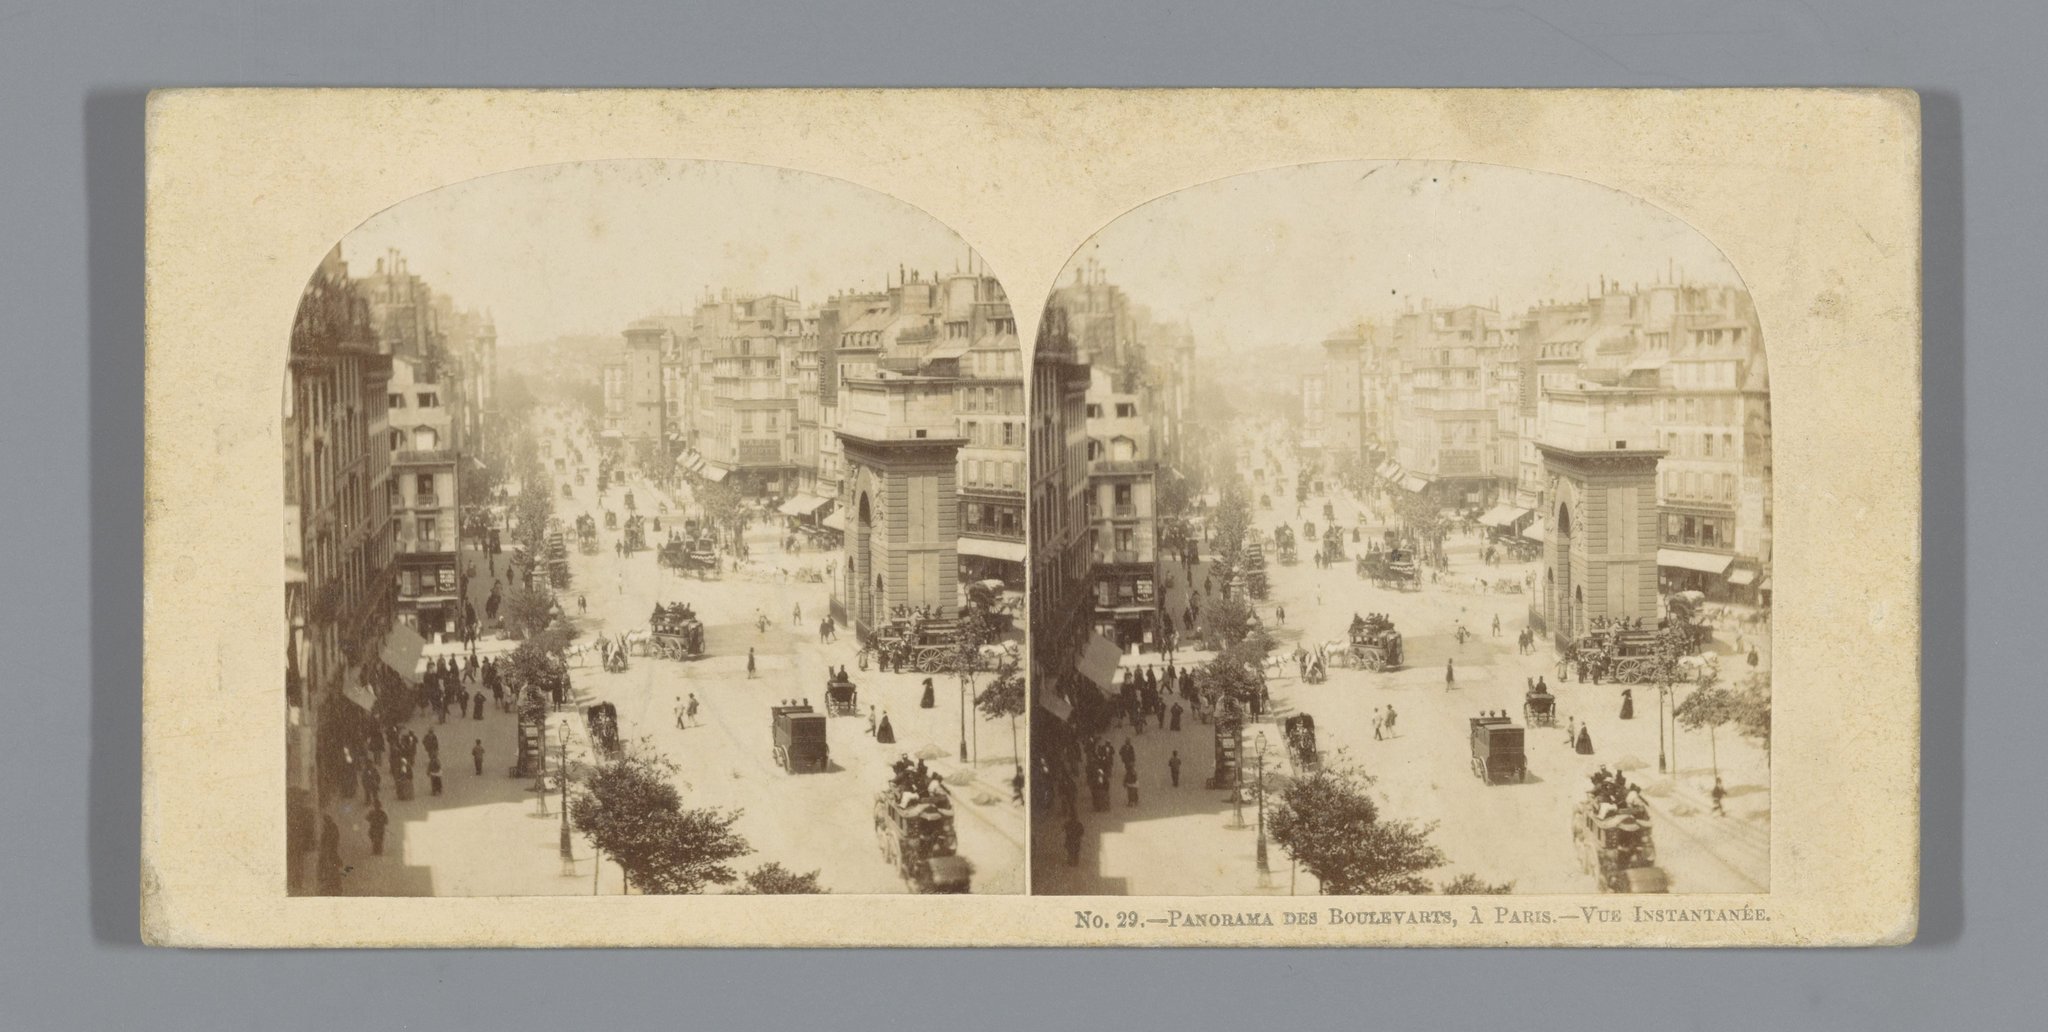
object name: stereograph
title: Panorama des Boulevards, à Paris-Vue Instantanée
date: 1850-1875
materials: cardboard, photographic support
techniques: albumen print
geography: paris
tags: triumphal arch, avenue, boulevard, promenade, esplanade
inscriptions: number: ‘No. 29.’